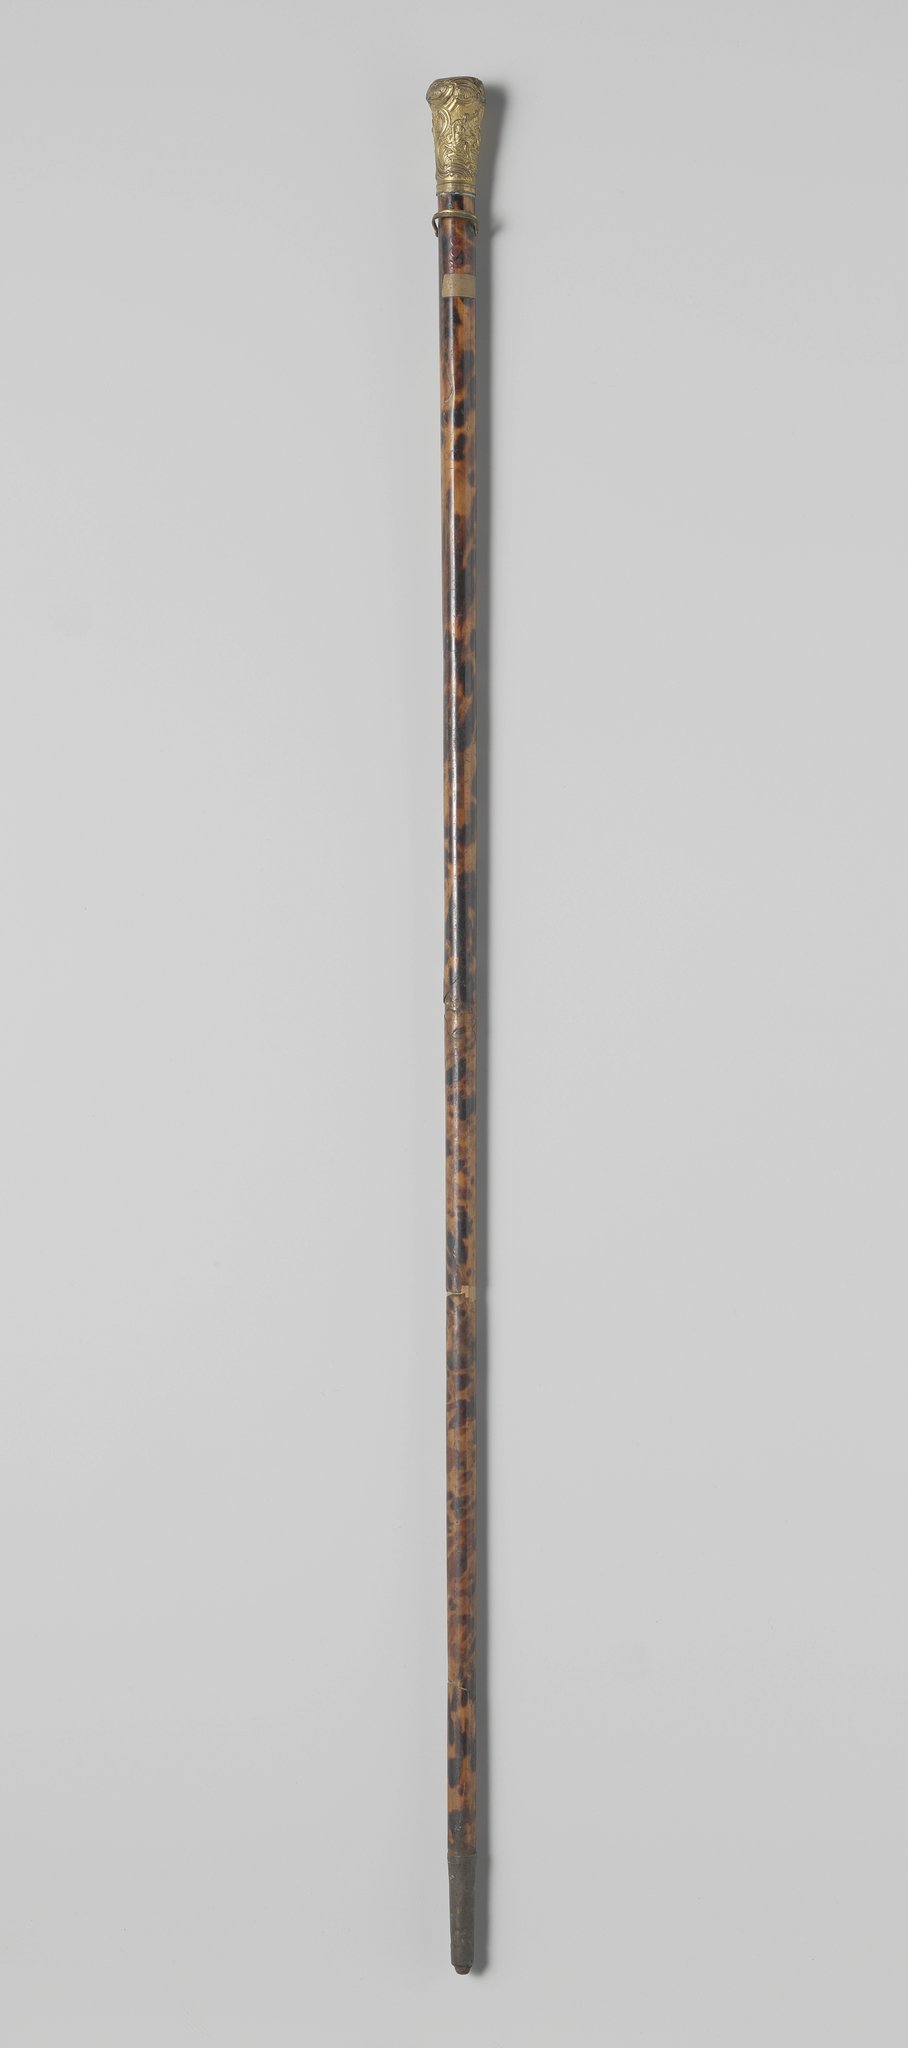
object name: walking stick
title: Wandelstok van hout waaromheen schildpad en waarop een vergulde knop, versierd met mythologische voorstellingen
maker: Anonymous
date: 1700-1800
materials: shell, wood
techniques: cutting, gilding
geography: netherlands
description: Wandelstok van hout waaromheen schildpad en waarop een vergulde knop, versierd met mythologische voorstellingen in reliëf. Metalen punt.